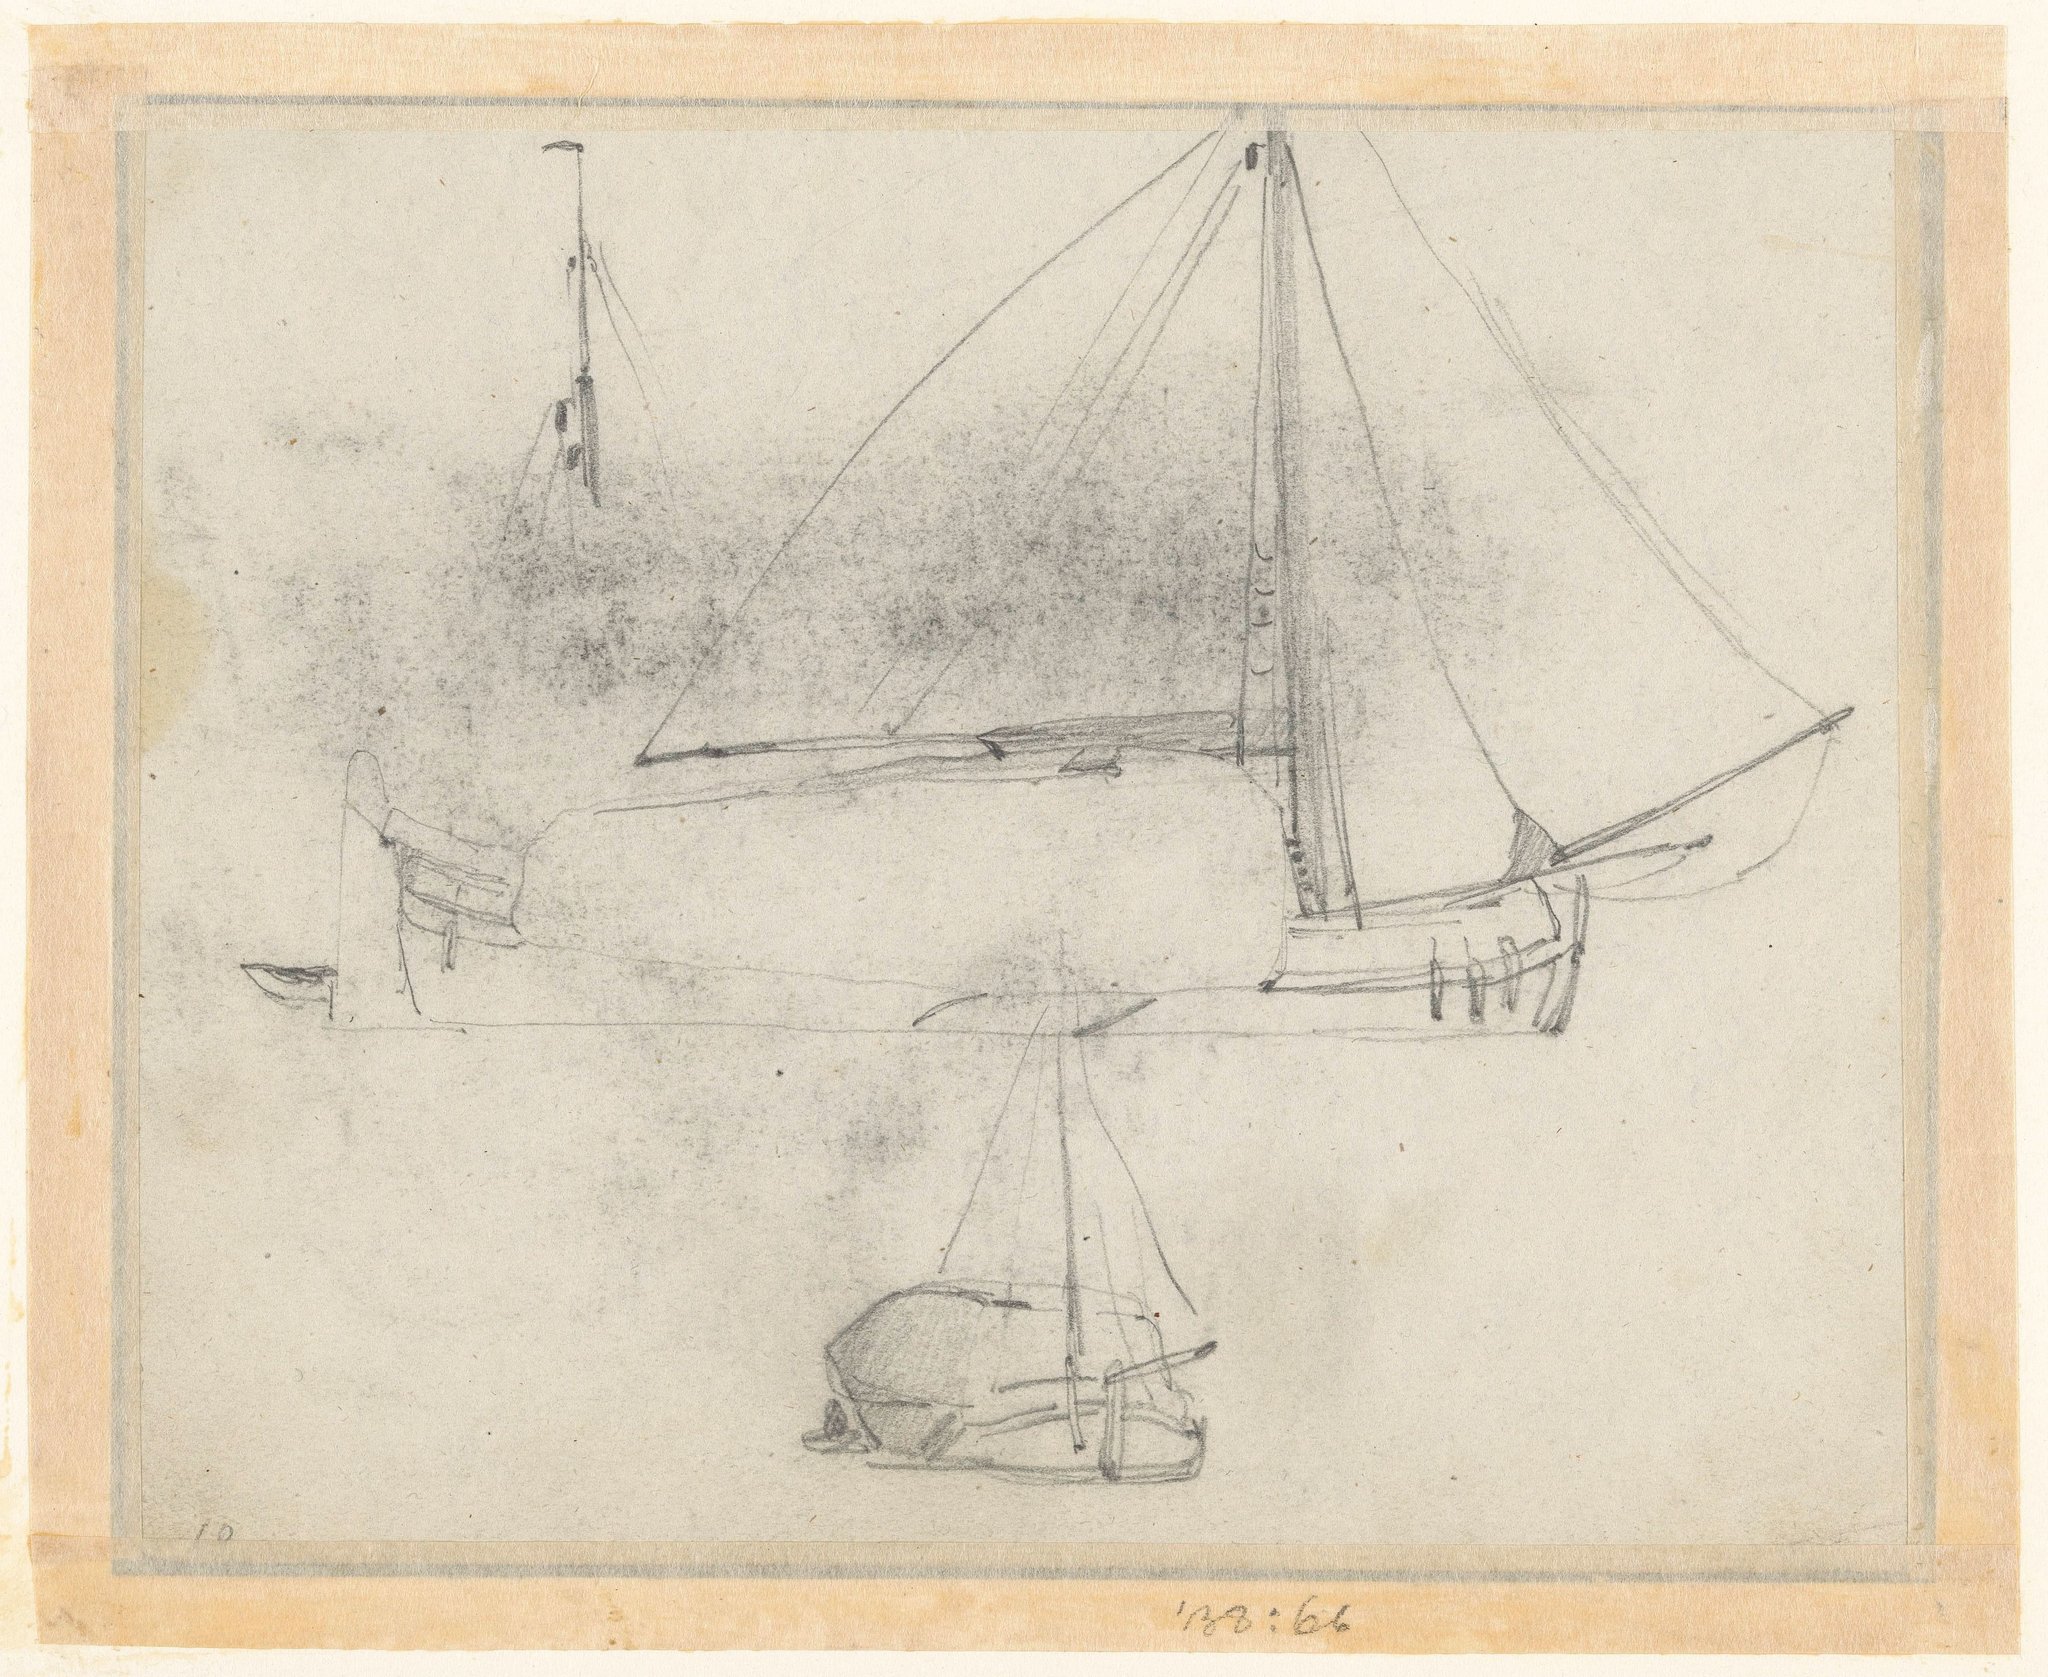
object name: drawing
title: Twee studies van zeilschepen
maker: jan weissenbruch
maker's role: painter, print maker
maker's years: 1822-1880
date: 1832-1880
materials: paper, pencil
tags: sailing-ship, sailing-boat